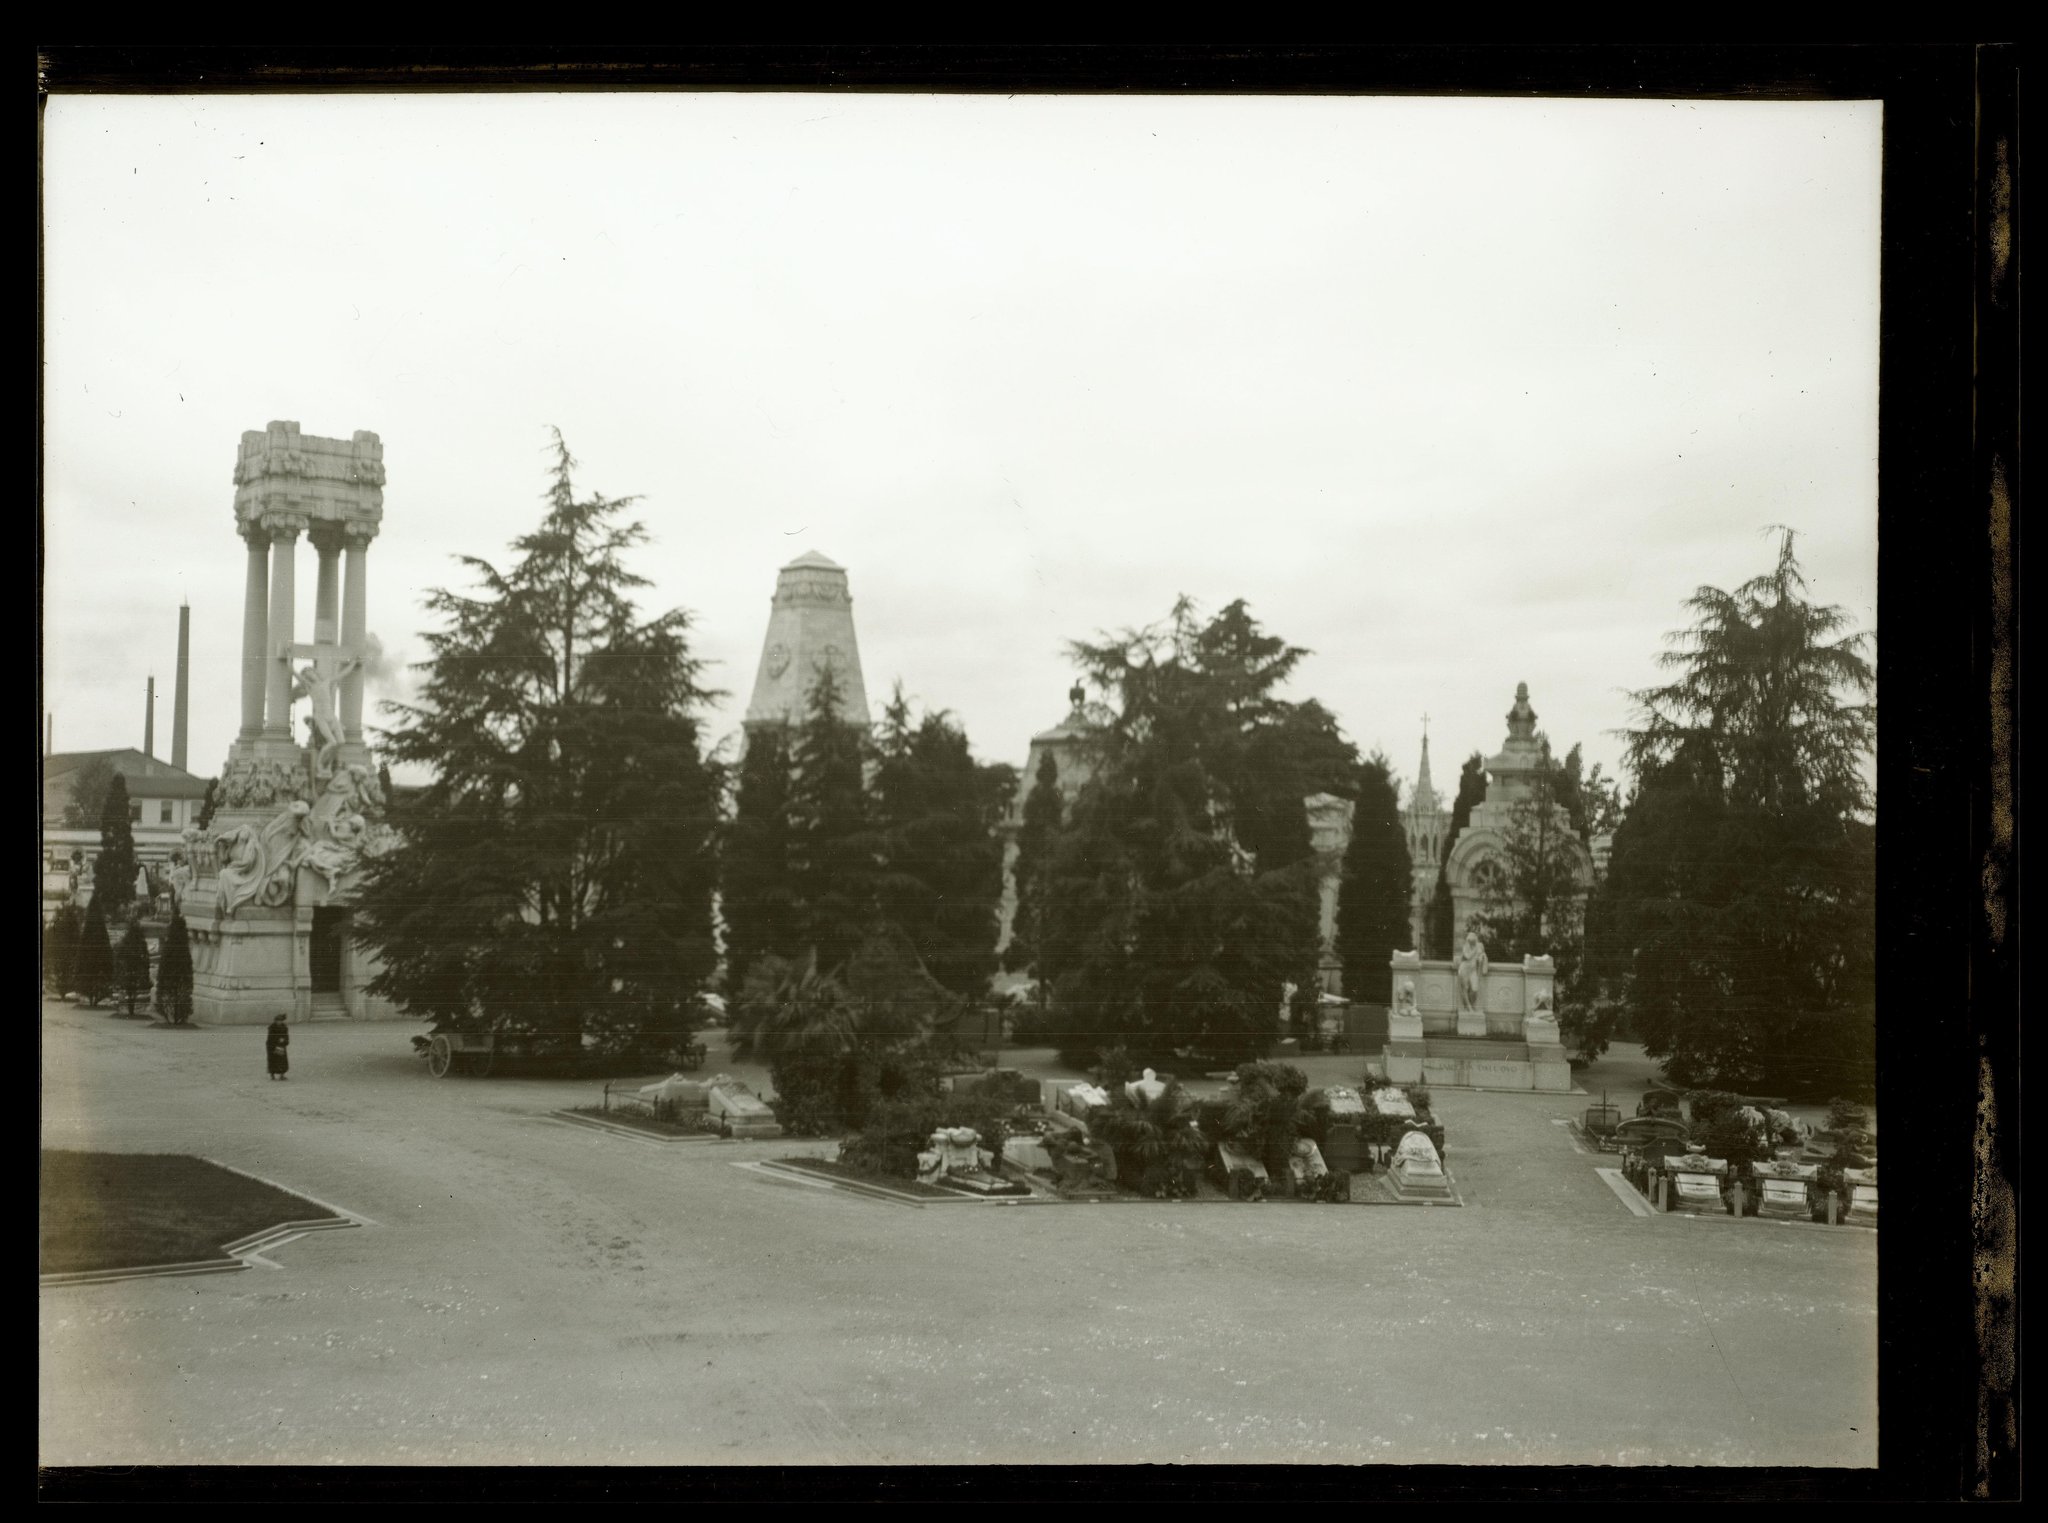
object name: negative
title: Filmnegatief met opname van Genua, Pisa, Ravenna of Milaan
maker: Anonymous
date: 1907-1935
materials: film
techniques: gelatin silver negative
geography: italy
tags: italy